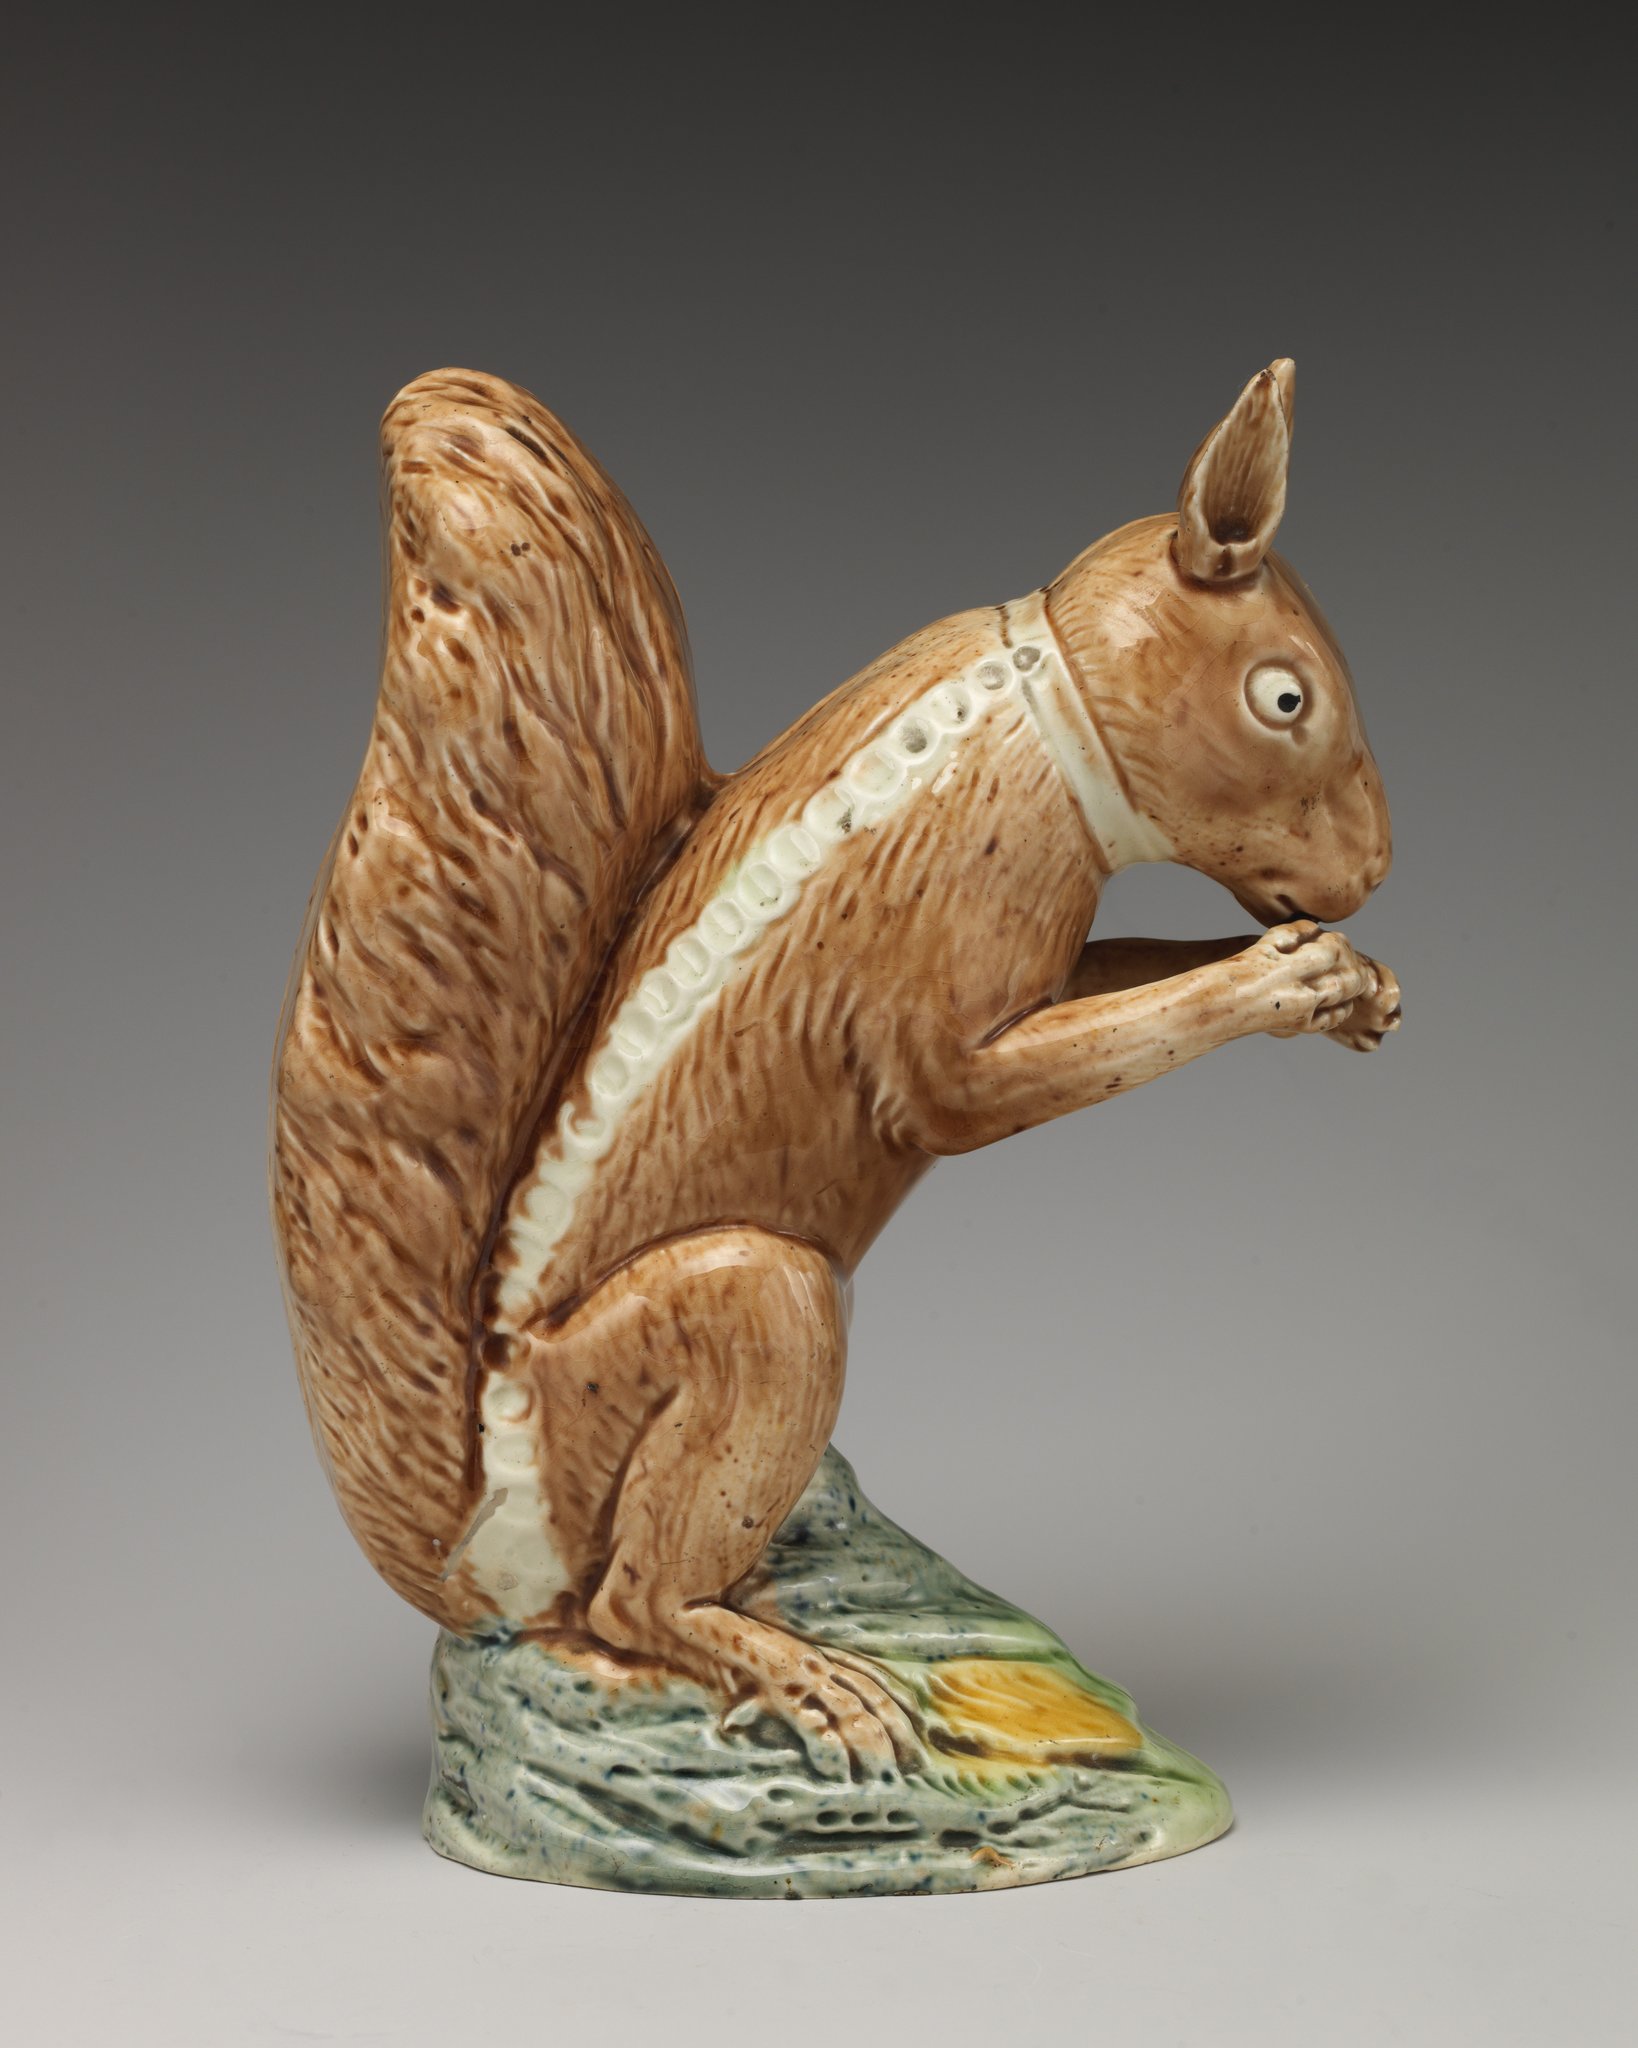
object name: figure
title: Brown squirrel with collar and chain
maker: ralph wood the younger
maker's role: maker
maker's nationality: british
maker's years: 1748-1795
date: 1770-1780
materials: earthenware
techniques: glazing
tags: squirrels